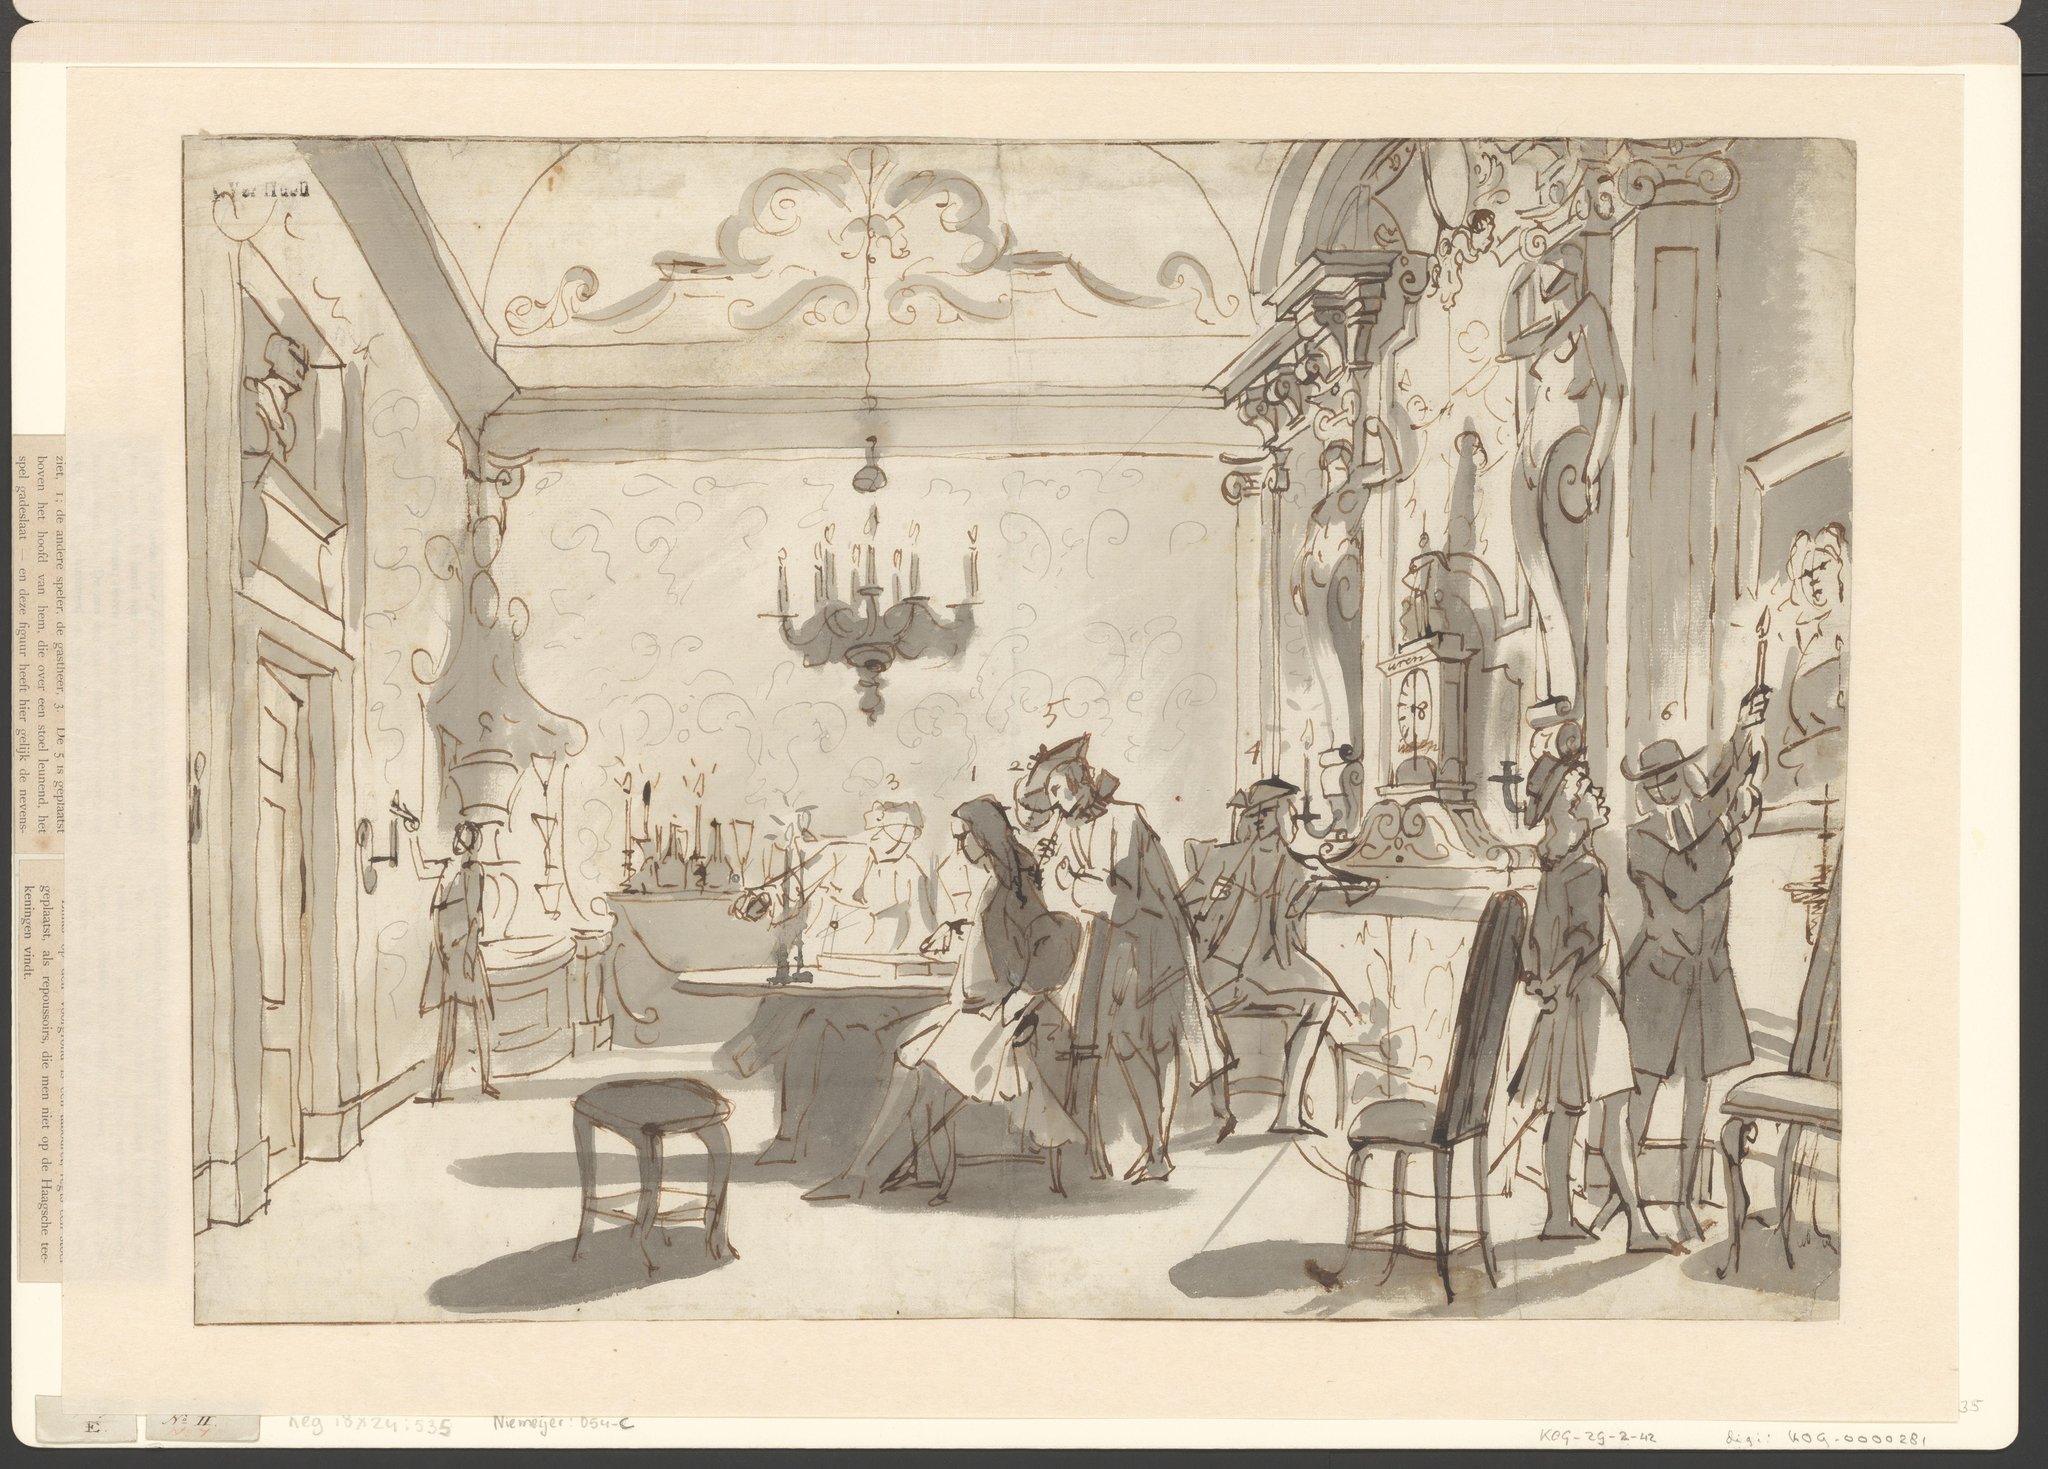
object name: drawing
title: Broers raken in gesprek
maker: cornelis troost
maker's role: draughtsman, painter, print maker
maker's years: 1696-1750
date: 1712-1750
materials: ink, paper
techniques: brush, pen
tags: drawing-room, 'salon', adult man, youth, adolescent, clock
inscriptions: collector's mark: Lugt 2488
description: Voorbereidende tekening voor een serie van vijf pastels. In de serie is het verloop van een avond te zien. De avond begint keurig en steeds verder uit de hand loopt door alcohol. Dit is de tweede tekening uit de serie.